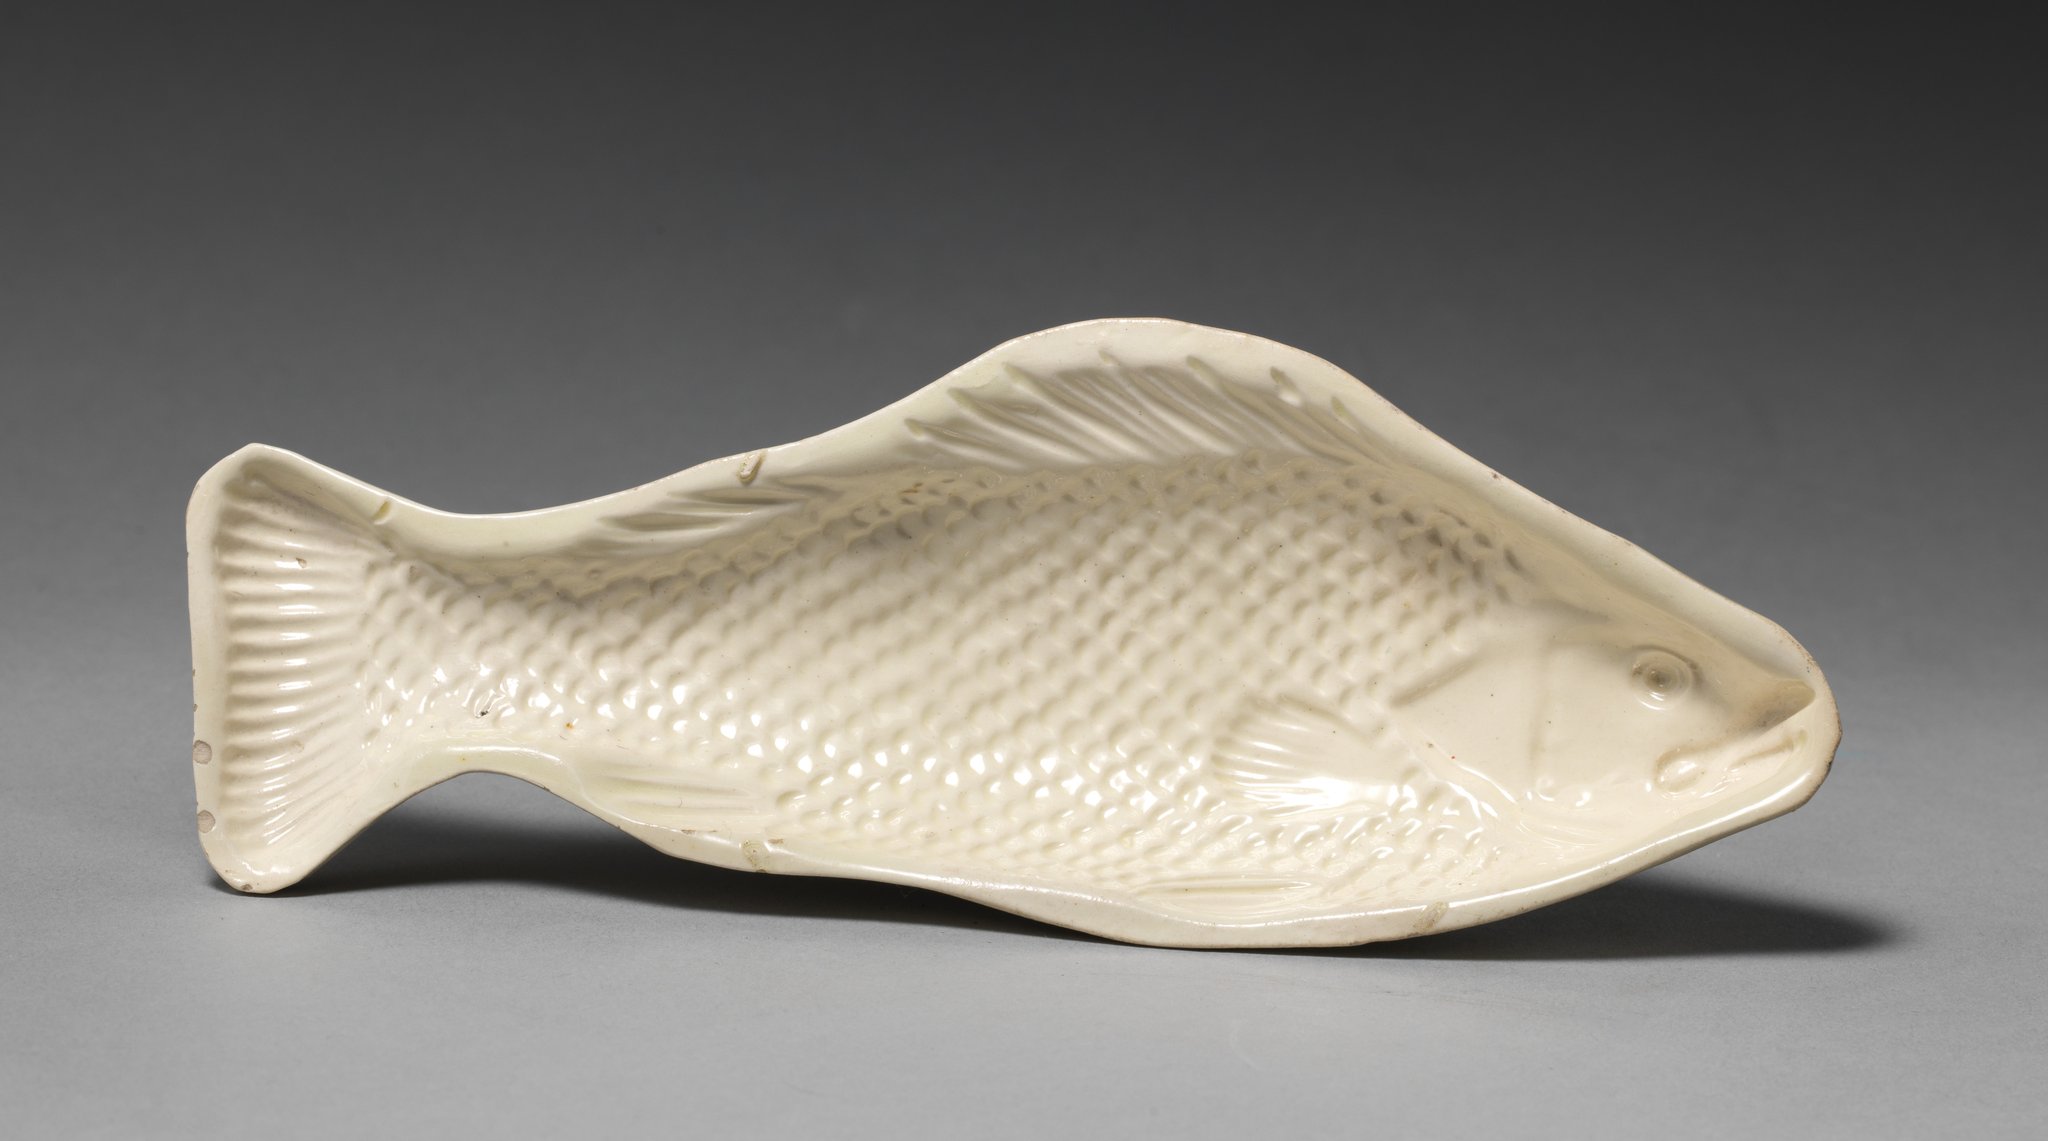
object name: pastry mold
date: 1775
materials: creamware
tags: fish